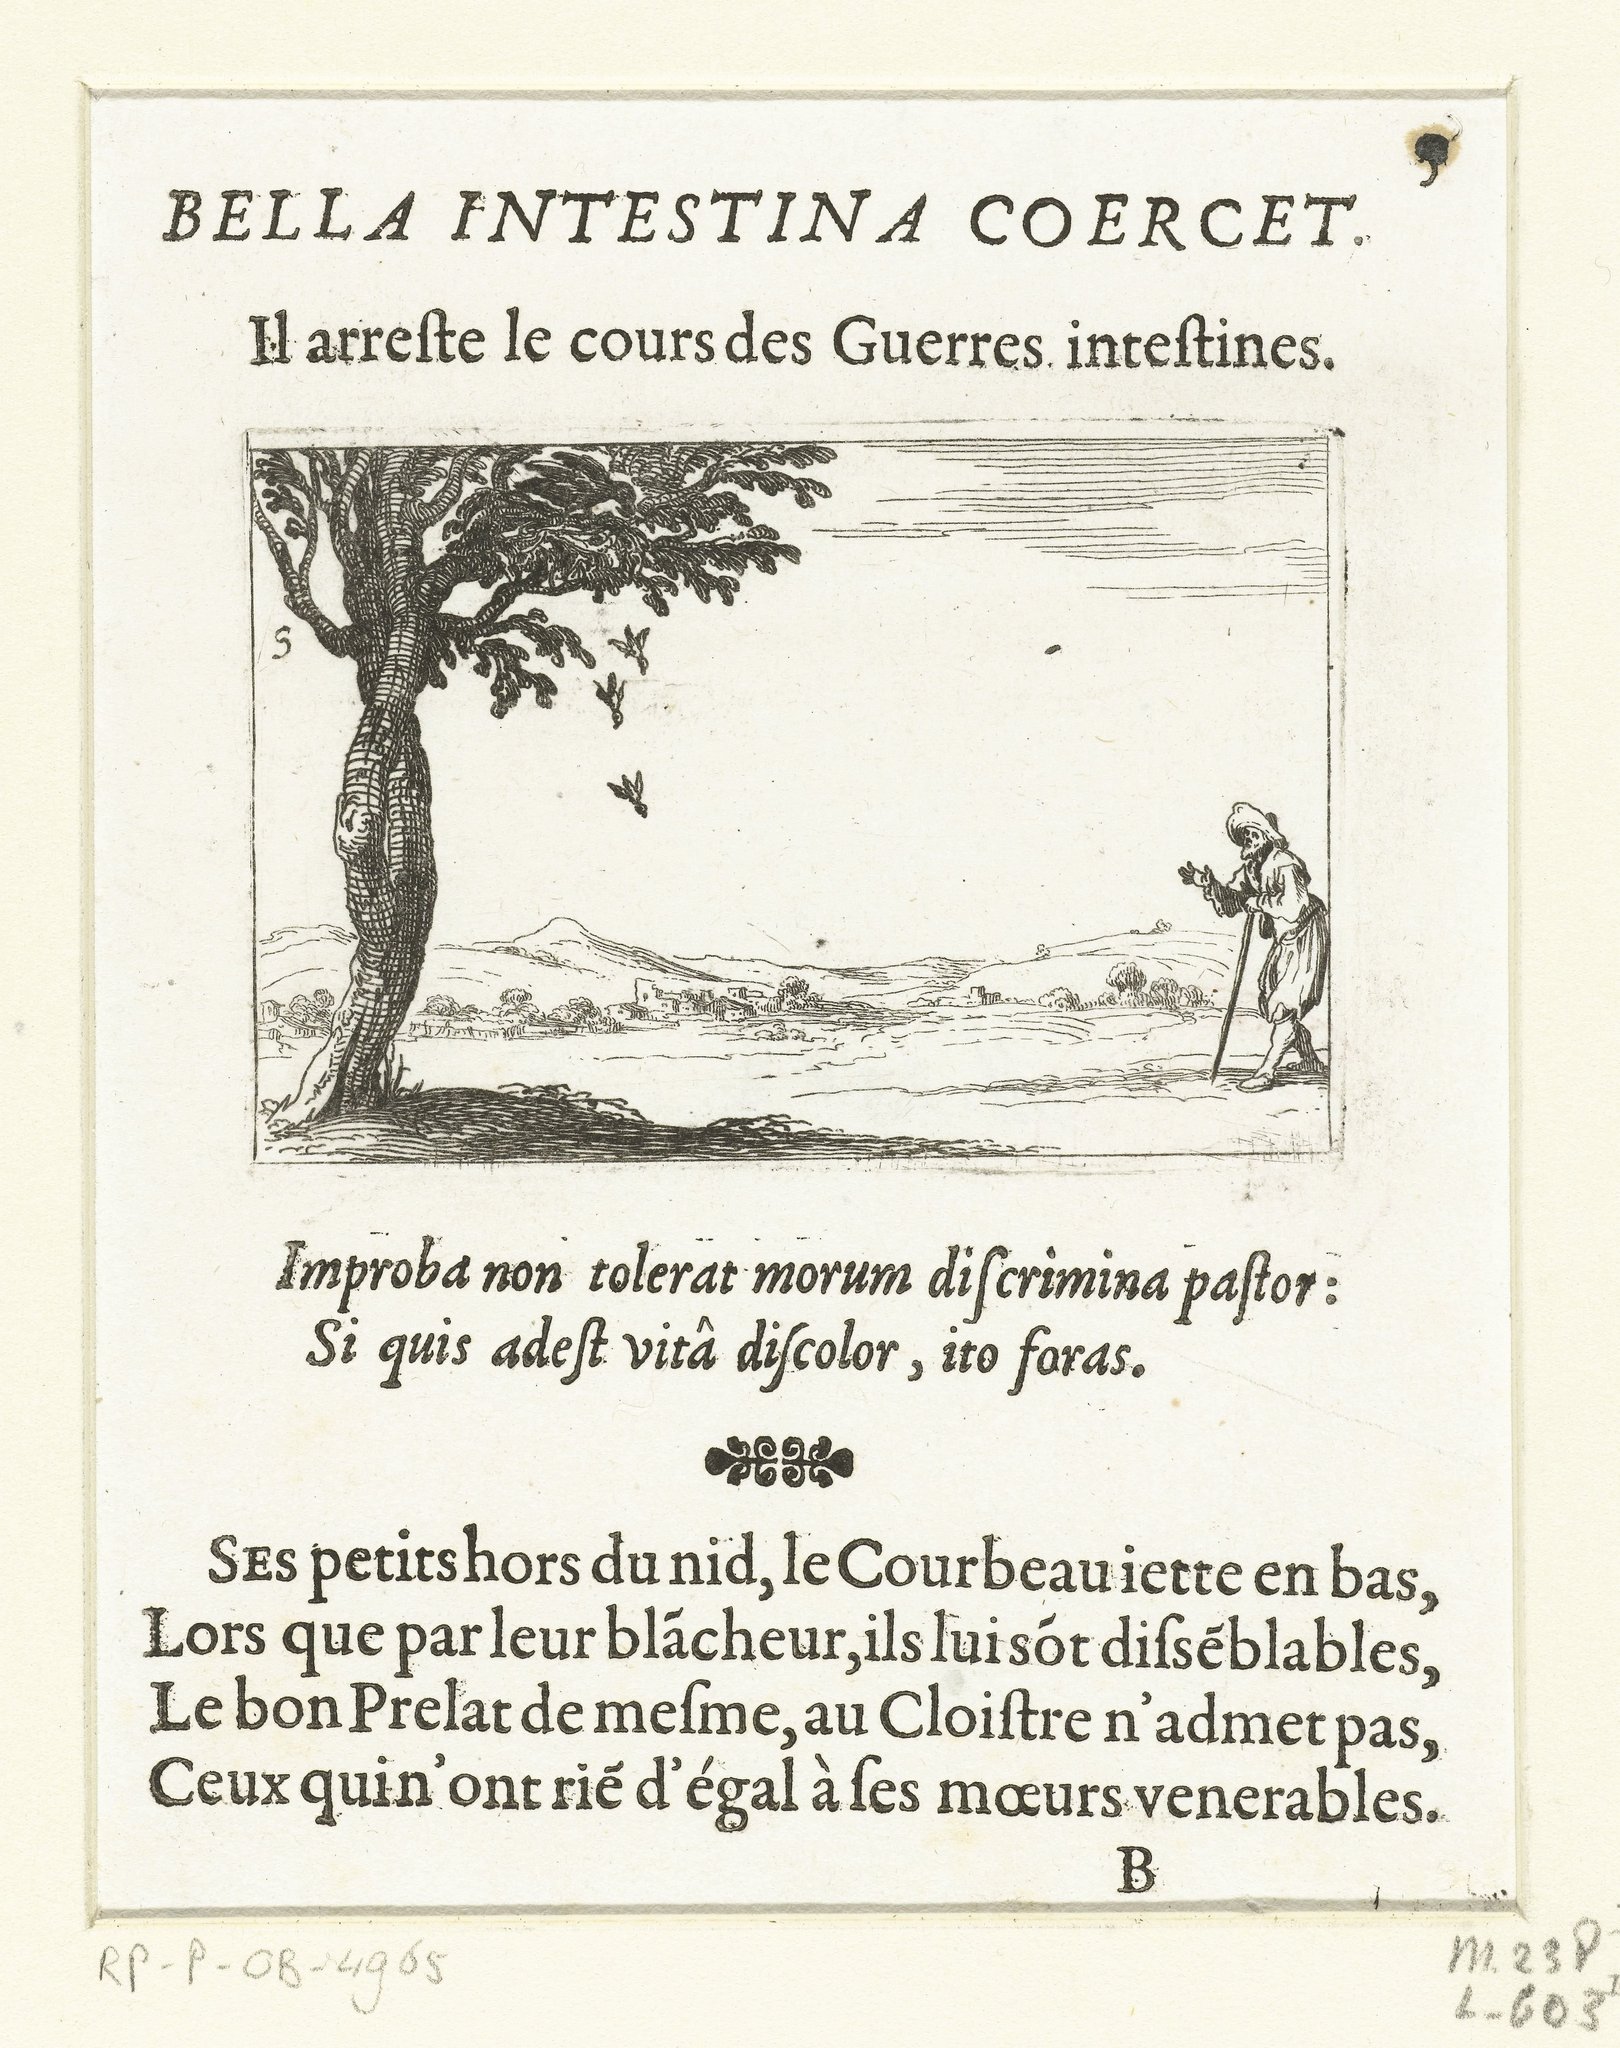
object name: cognizance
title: Kloosterleven in emblemen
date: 1621-1635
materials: paper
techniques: etching, letterpress printing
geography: paris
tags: song-birds: raven, animals (+ nest, den, burrow)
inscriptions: collector's mark: Lugt 240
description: Voorstelling van een raaf die enkele jongen (degene met witte veren) uit zijn nest duwt. Een man met een wandelstok kijkt toe. Boven en onder deze prent Latijnse en Franse teksten in boekdruk. Dit blad is onderdeel van de embleemserie 'Kloosterleven in emblemen'. De tweede staat van deze serie behelst naast een geïllustreerde titelpagina en 26 emblemen nog een titelpagina en een blad met opdracht, beide in boekdruk zonder afbeelding.